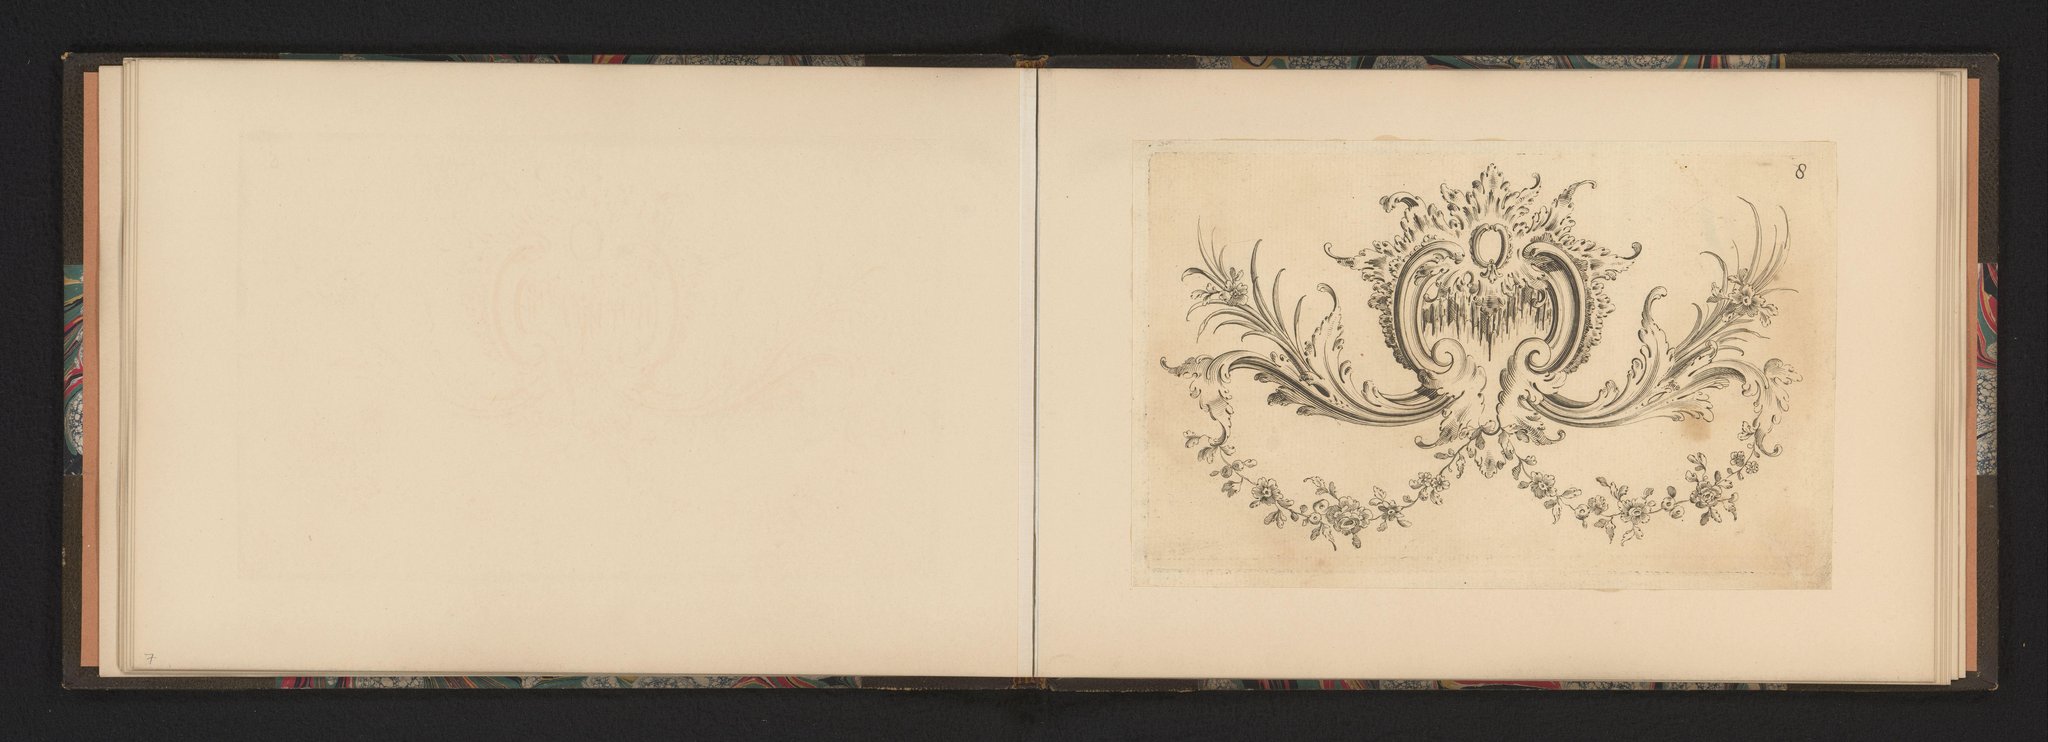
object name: print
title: Ornamentele versiering met c-voluten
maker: p. baretti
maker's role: print maker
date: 1766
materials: paper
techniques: engraving, etching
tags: ornaments ~ art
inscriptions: number: ‘8’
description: Ingeplakte prent met ornamentele versiering met c-voluten. Prent maakt deel uit van een album.